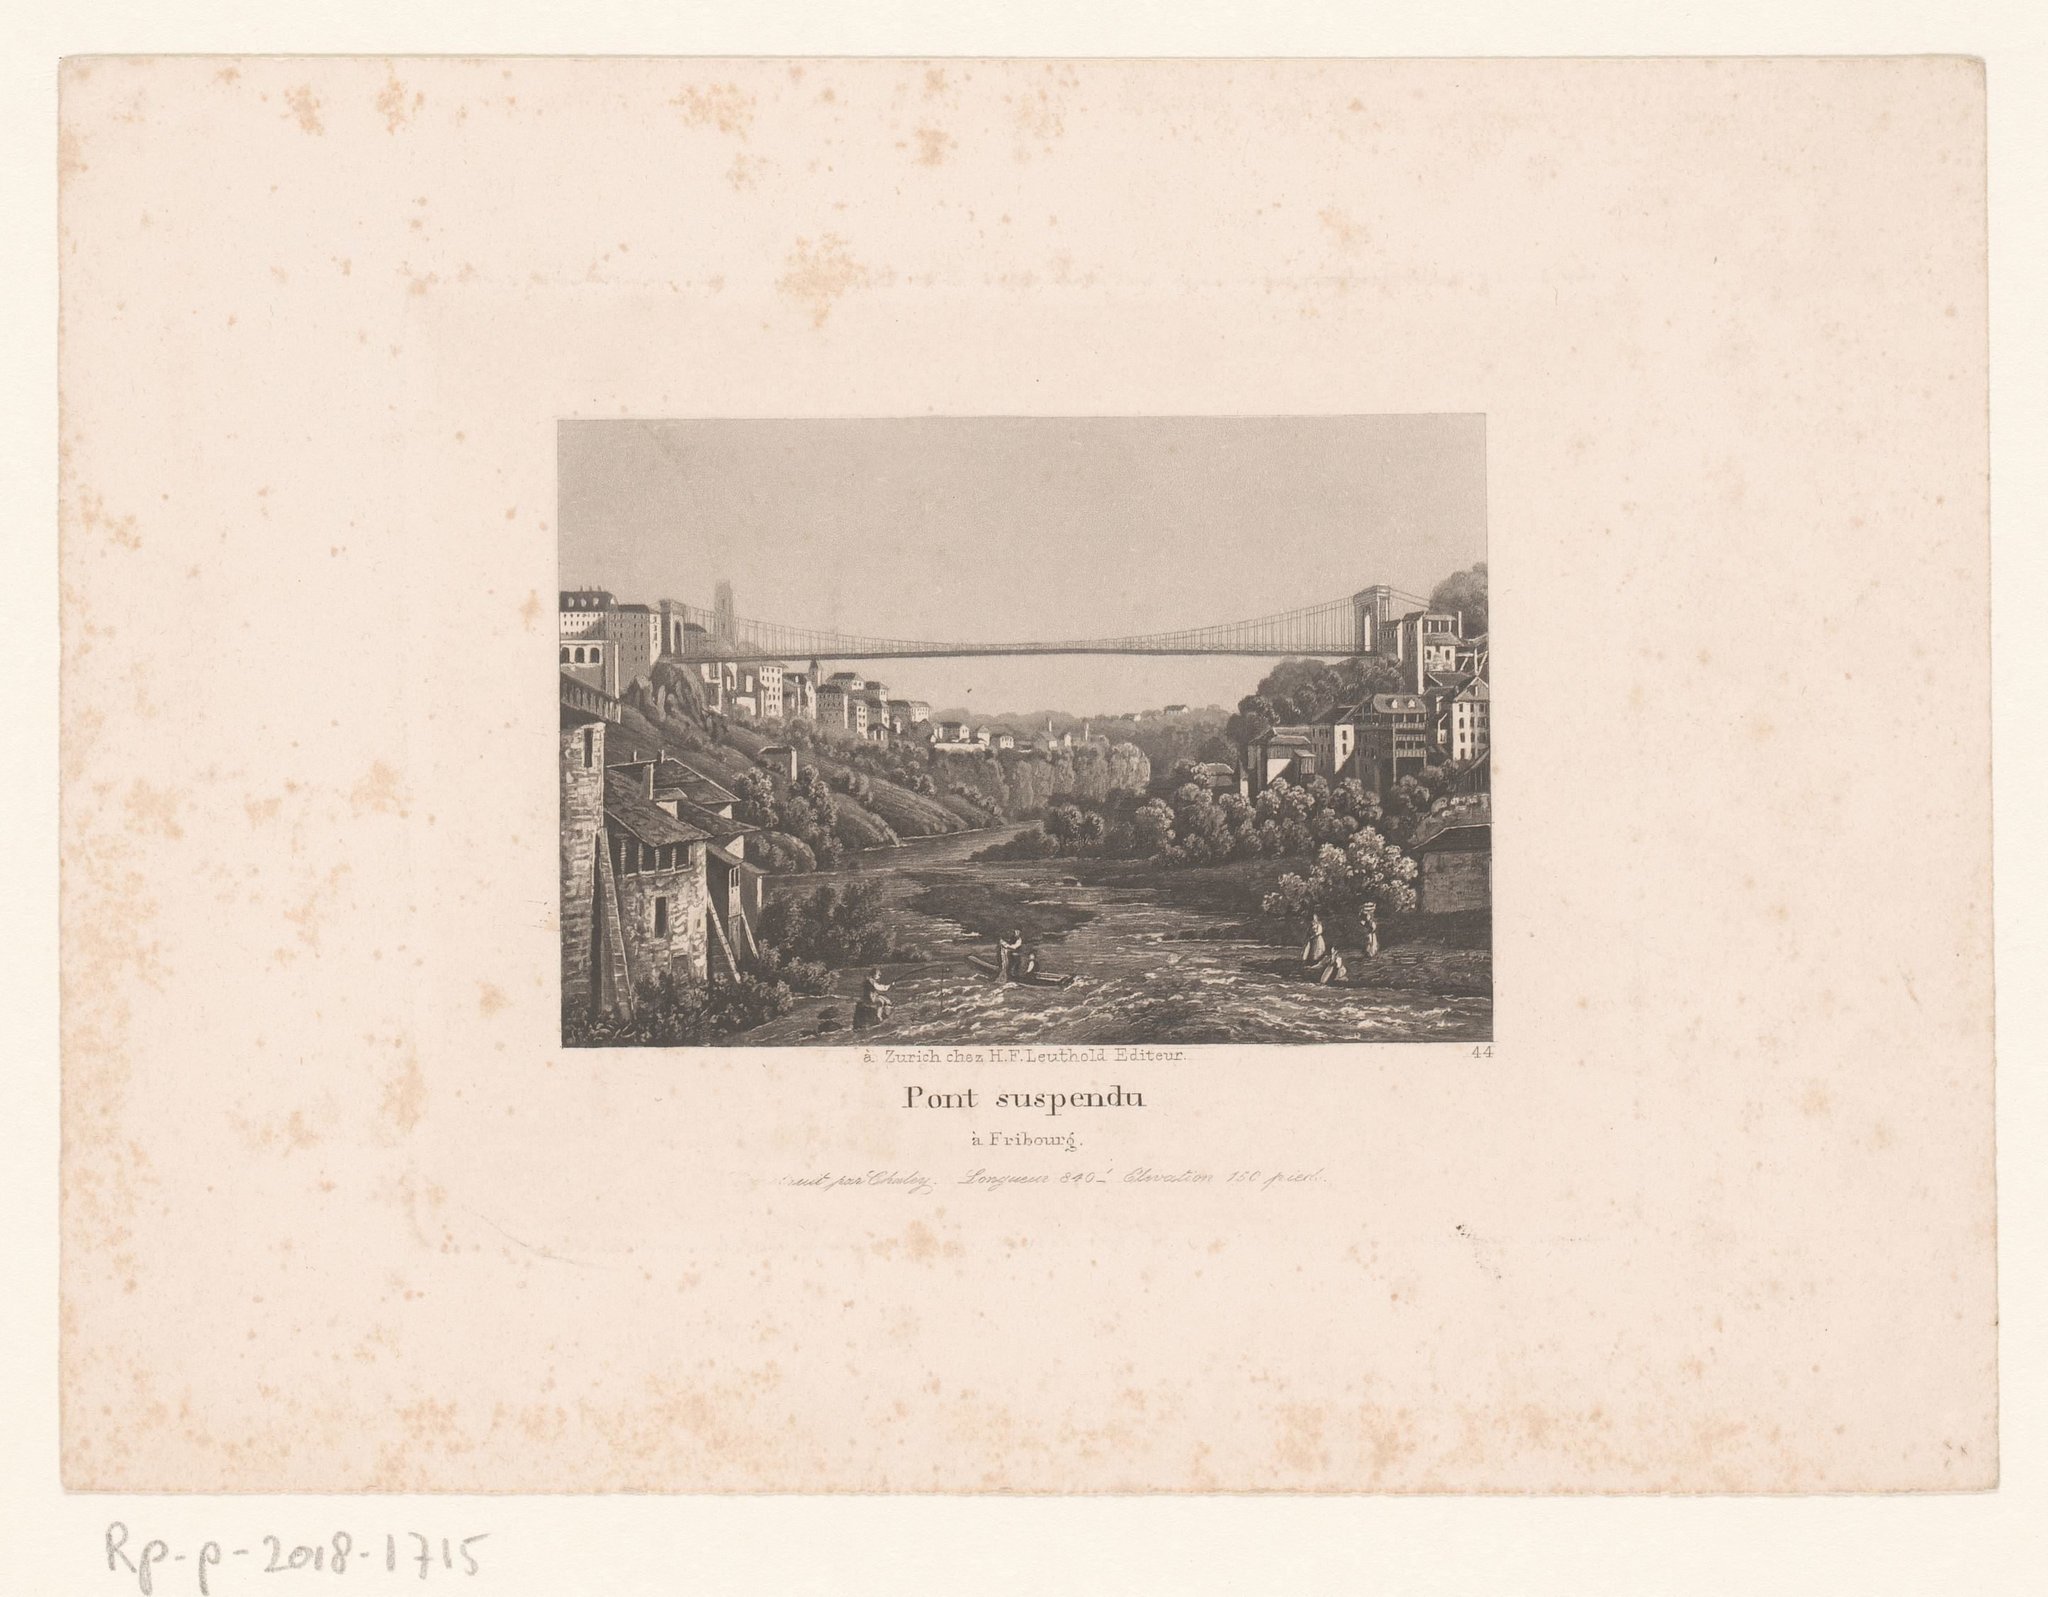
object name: print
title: Pont suspendu à Fribourg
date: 1800-1849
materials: paper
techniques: aquatint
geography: zurich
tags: bridge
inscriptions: collector's mark: Lugt 2228